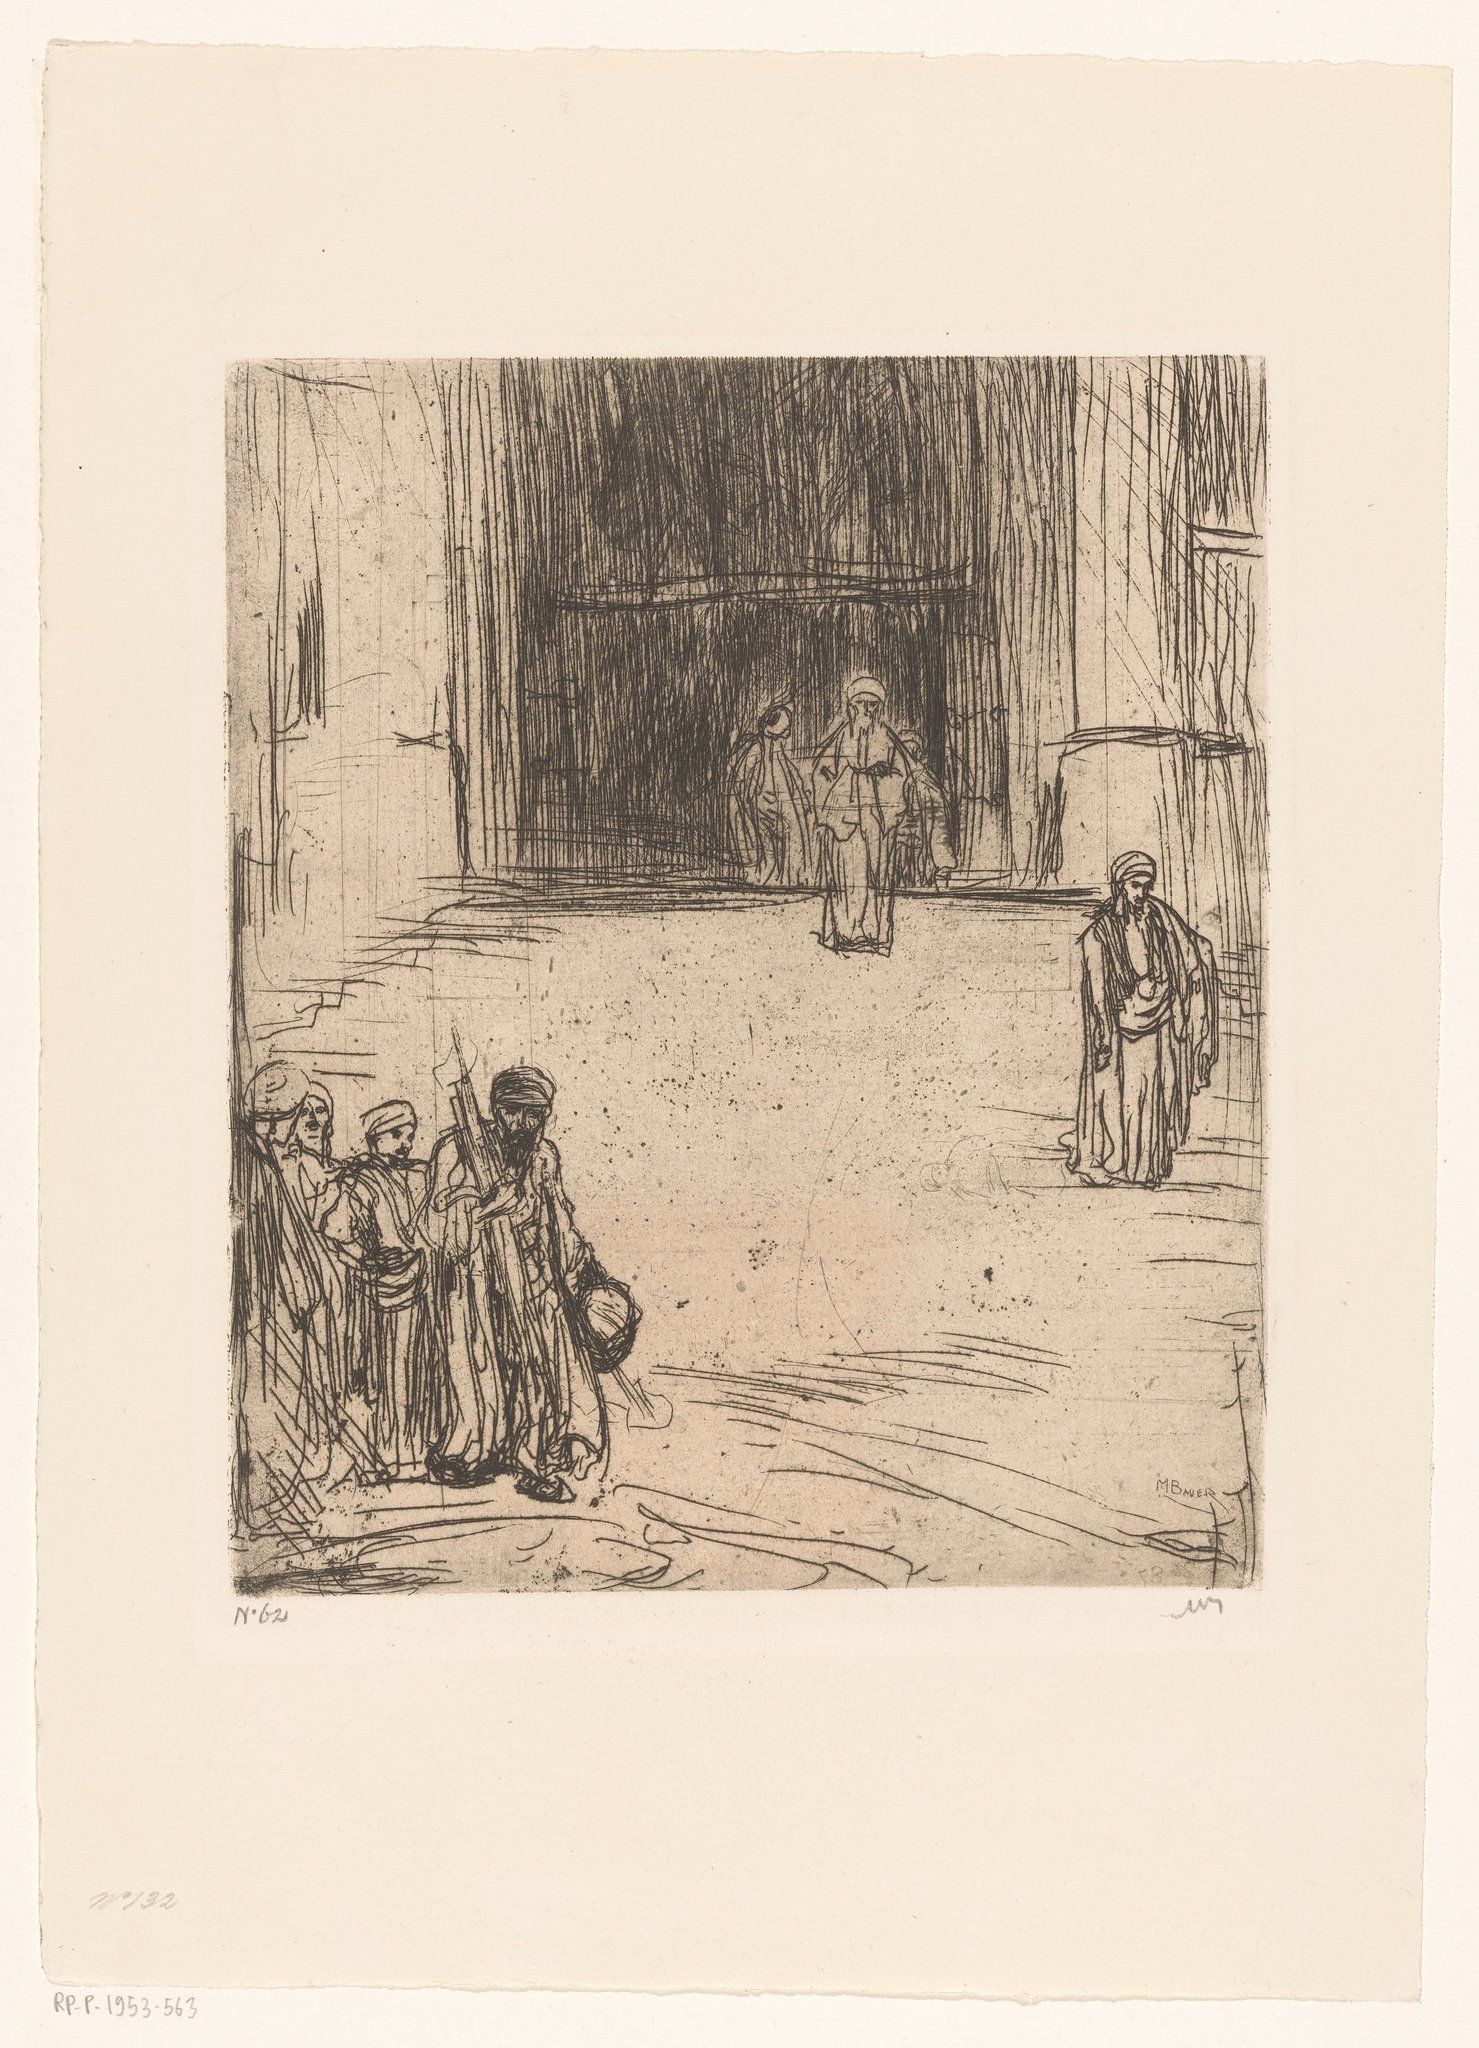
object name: print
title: Moskee in Constantinopel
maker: marius bauer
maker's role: draughtsman, print maker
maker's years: 1867-1932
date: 1889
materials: paper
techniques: etching, intaglio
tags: firearms: rifle, temple, shrine ~ islam, mohammedanism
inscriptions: collector's mark: Lugt 2228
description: Verschillende mannen verlaten een moskee via een trap. Links op de voorgrond een groep mannen waarvan er één een geweer bij zich draagt.